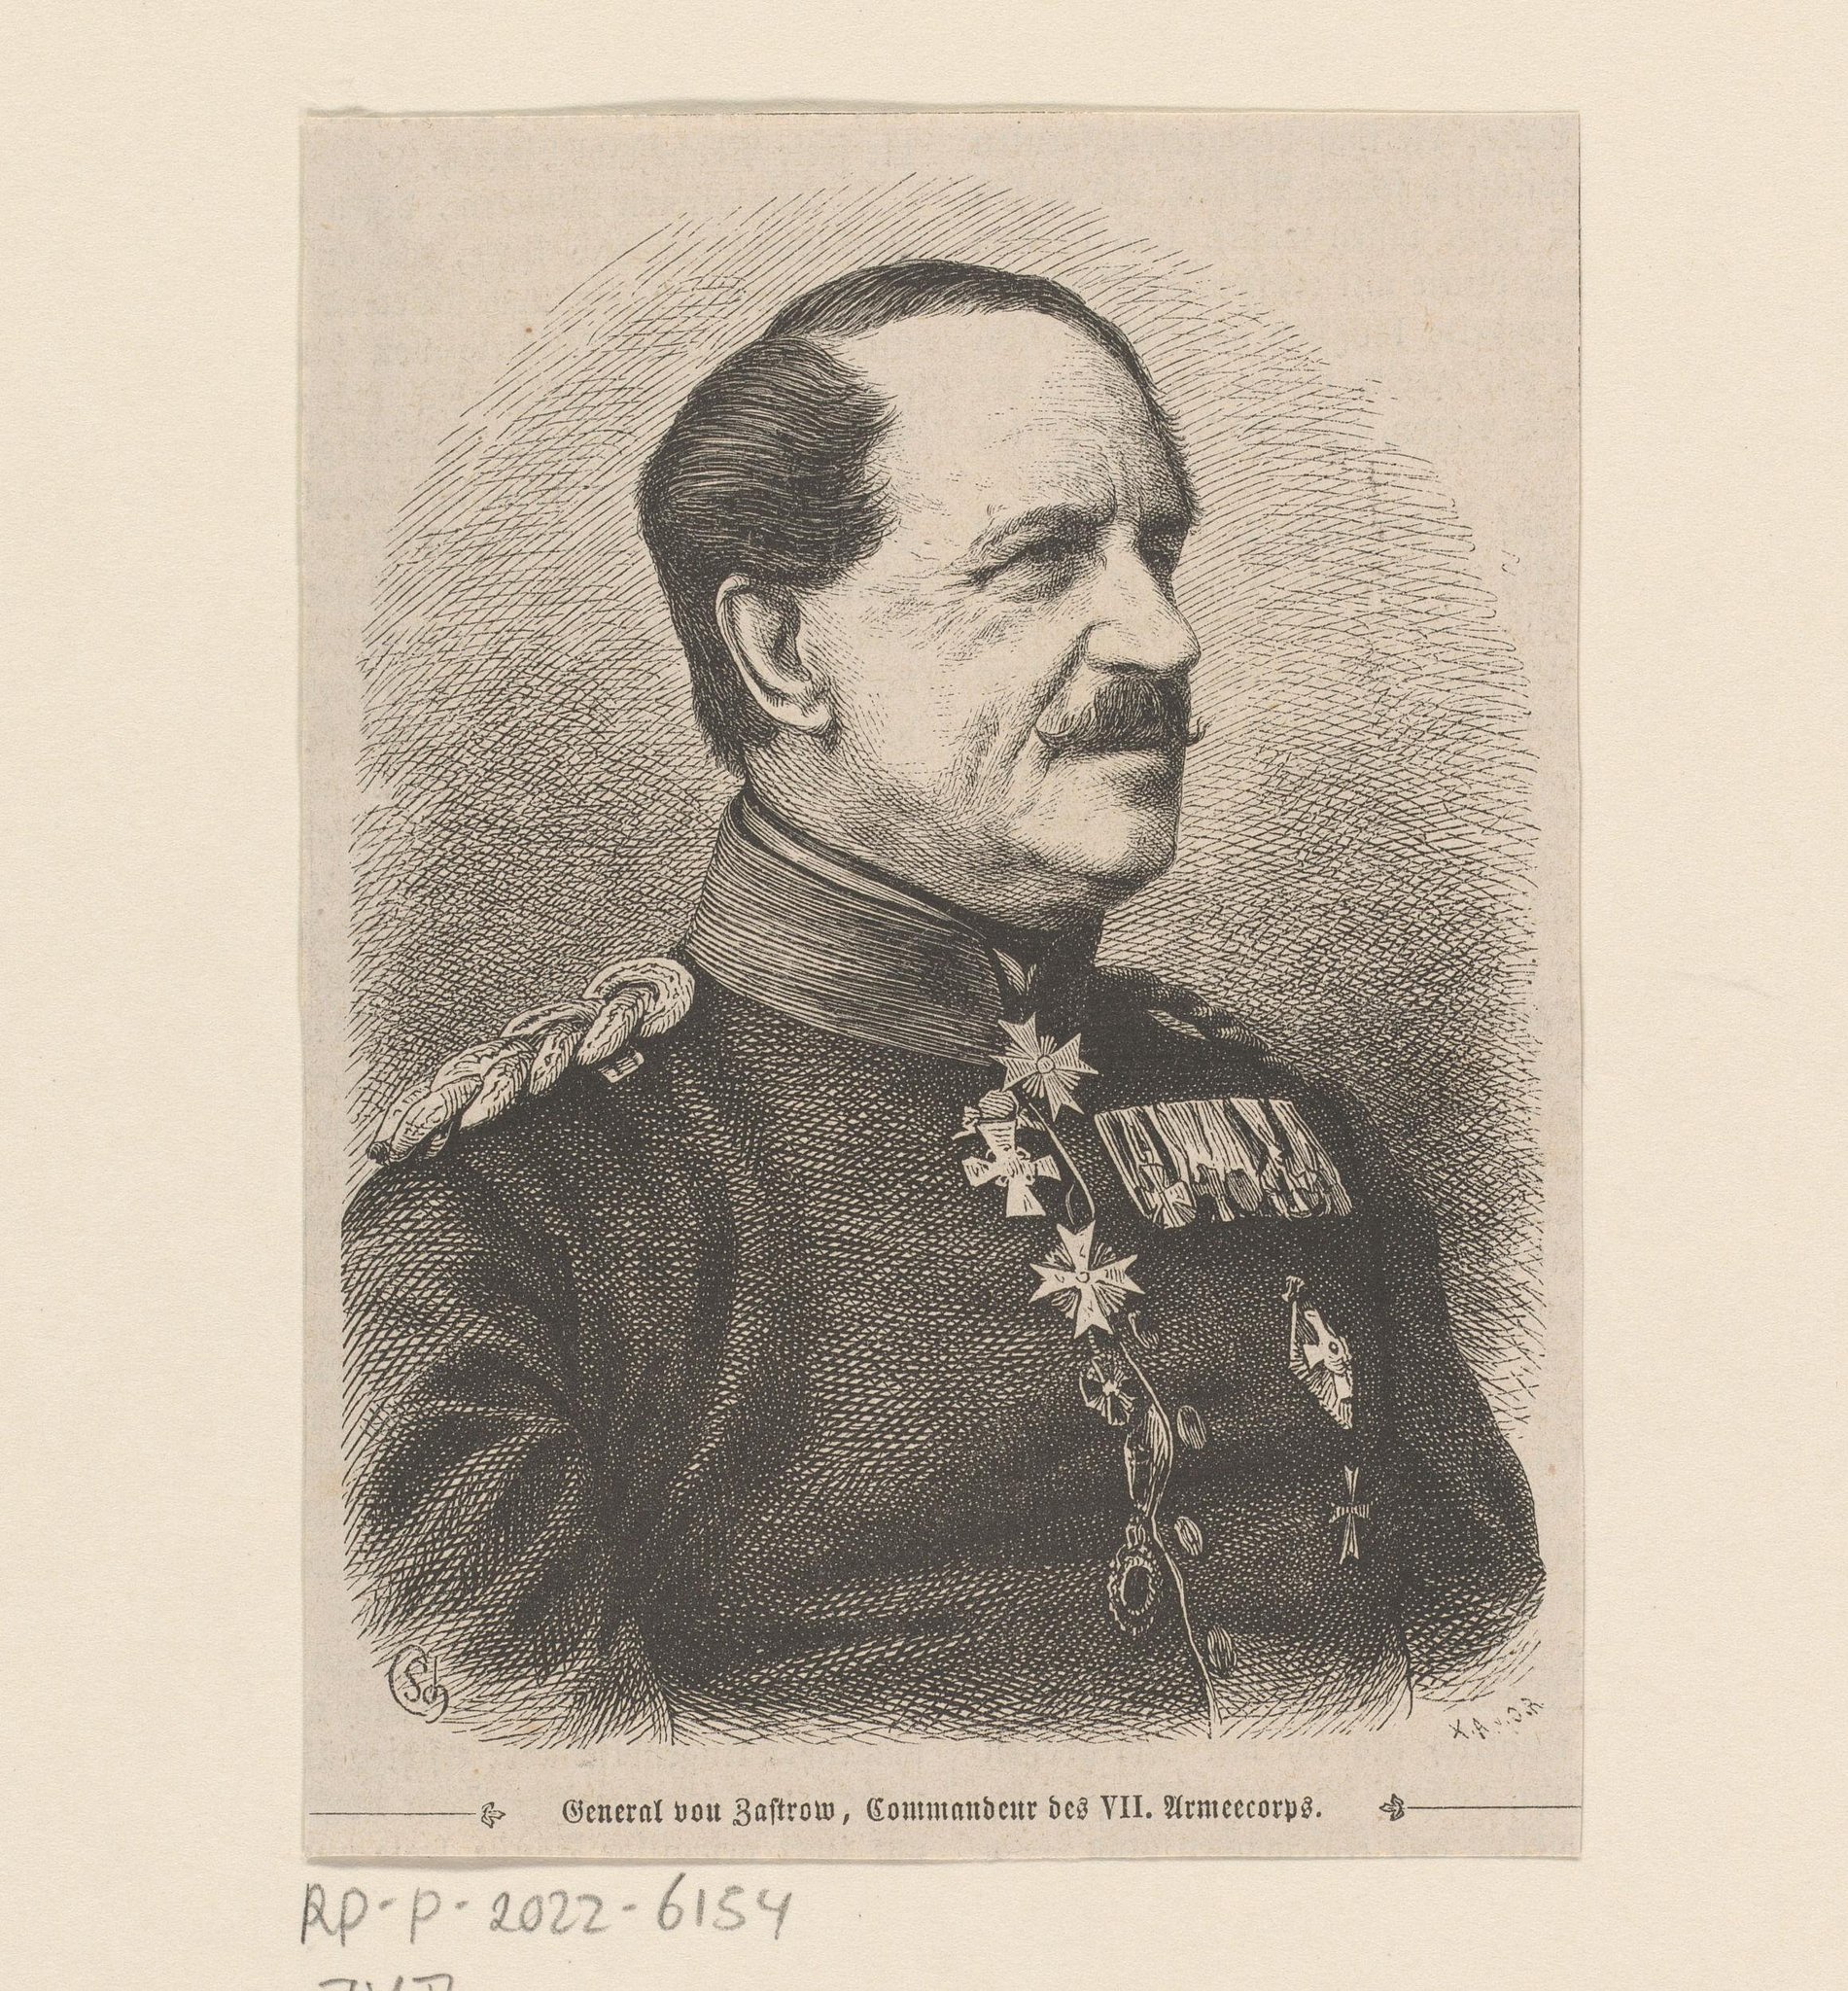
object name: book illustration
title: Portret van Heinrich Adolf von Zastrow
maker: Anonymous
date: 1870-1875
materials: paper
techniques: letterpress printing, engraving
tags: historical persons, officer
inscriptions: stamp: ‘JVB’